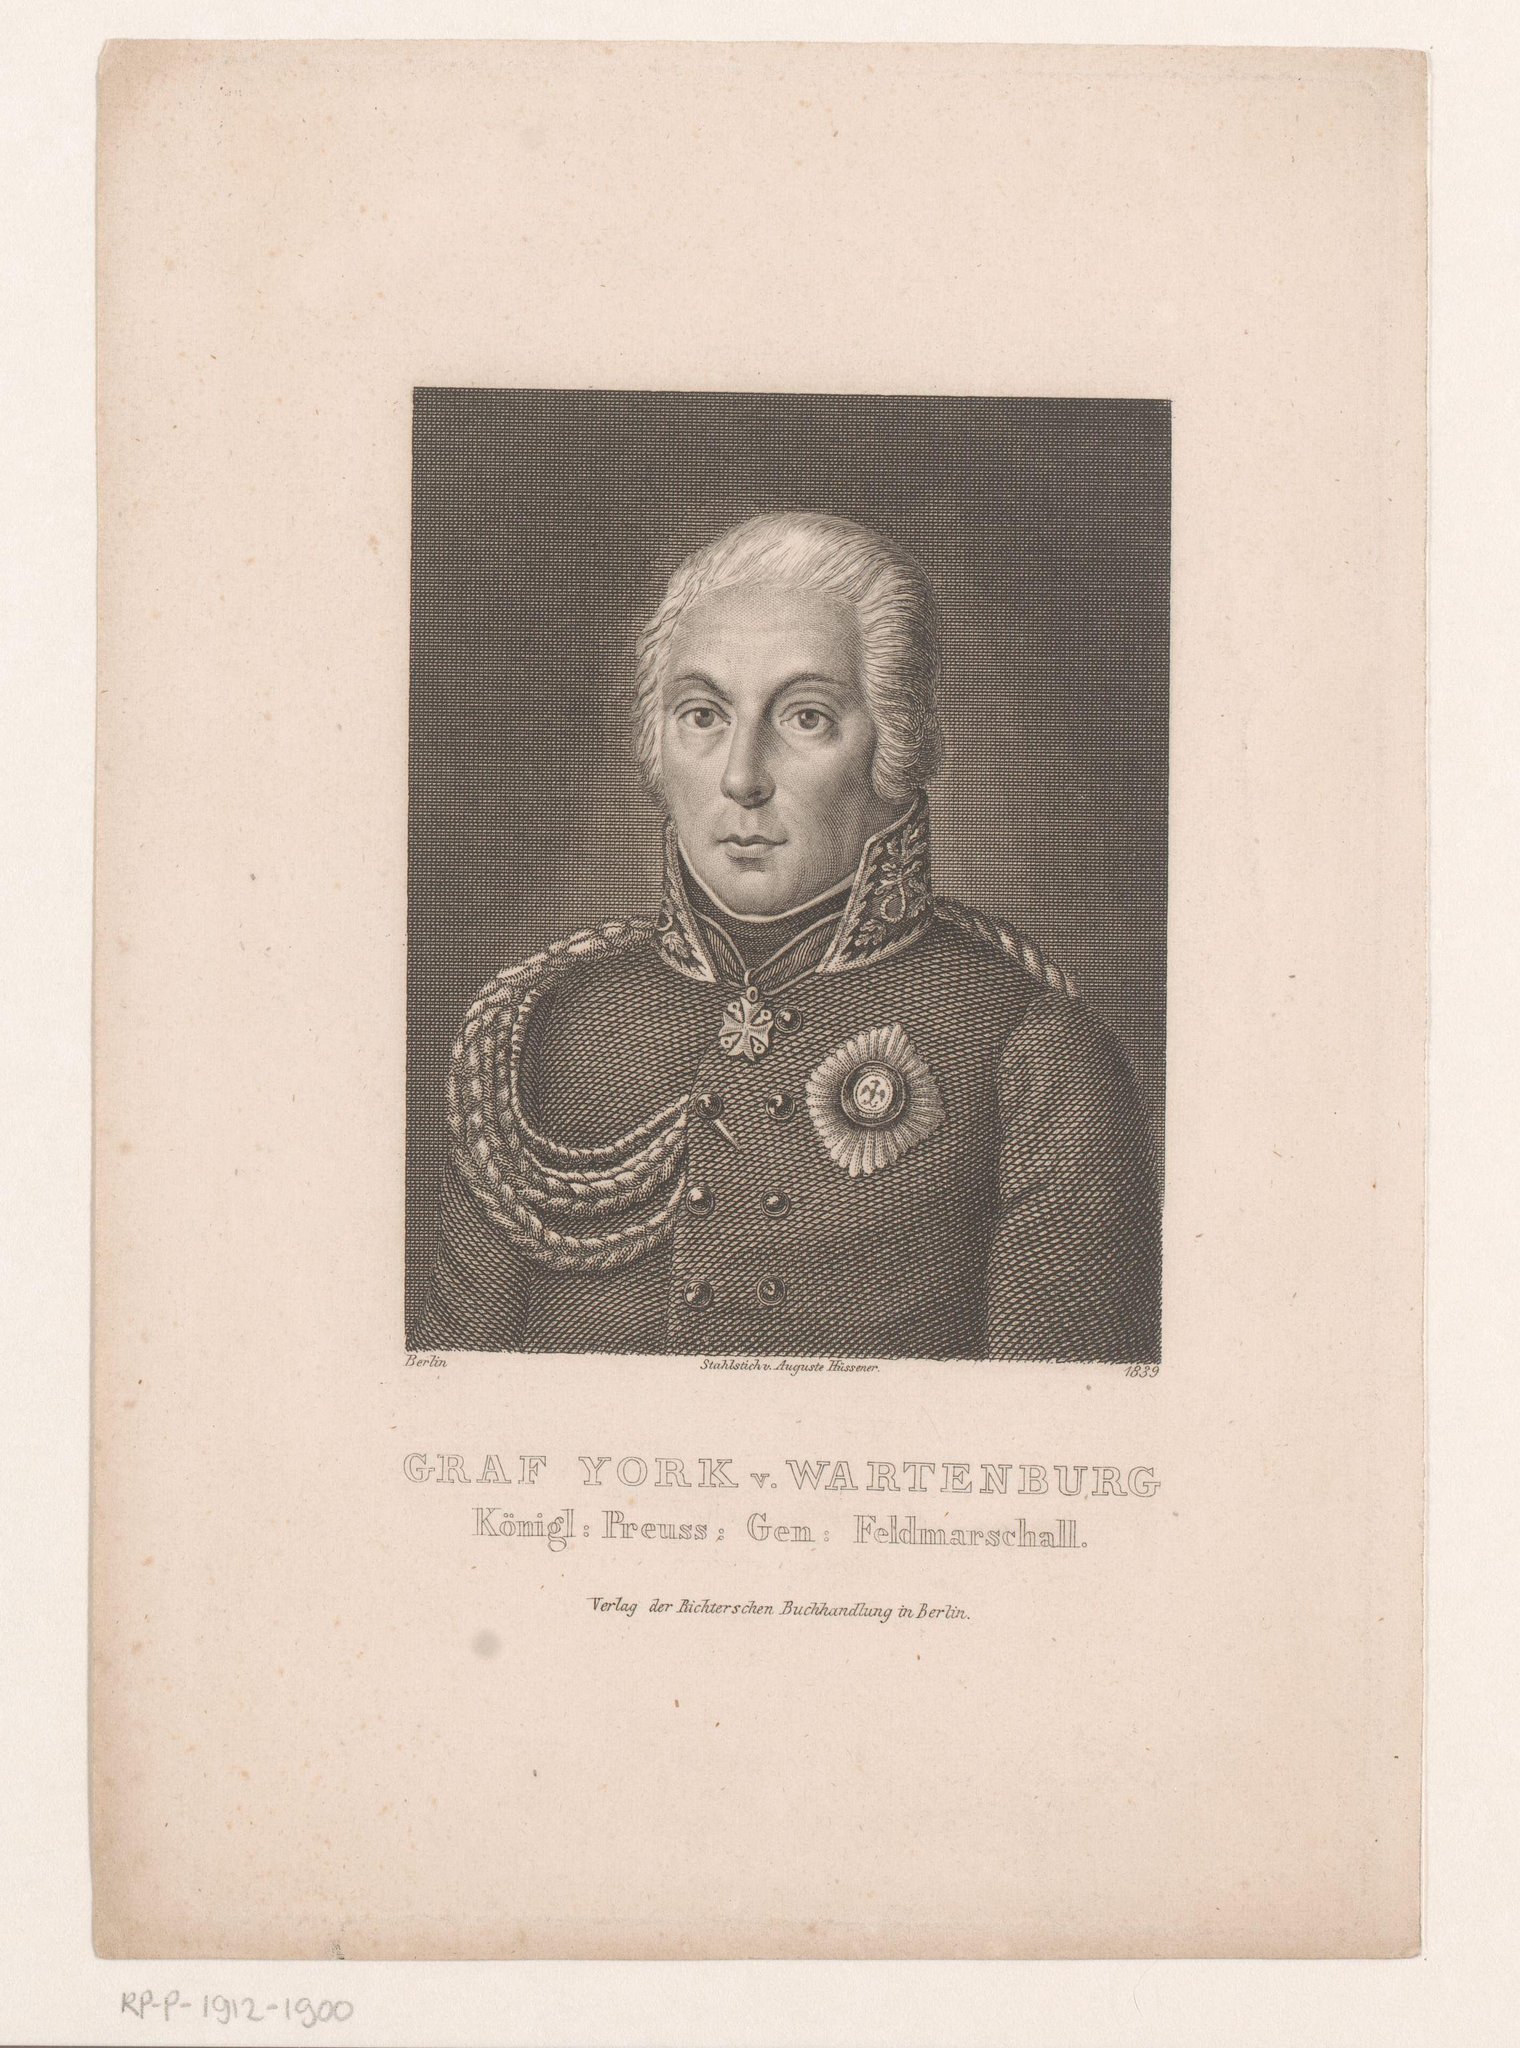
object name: print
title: Portret van Johann Yorck von Wartenburg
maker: auguste hüssener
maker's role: print maker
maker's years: 1789-1877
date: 1839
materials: paper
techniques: engraving, etching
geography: berlin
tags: commander-in-chief, general, marshal, historical persons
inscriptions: collector's mark: Lugt 2228